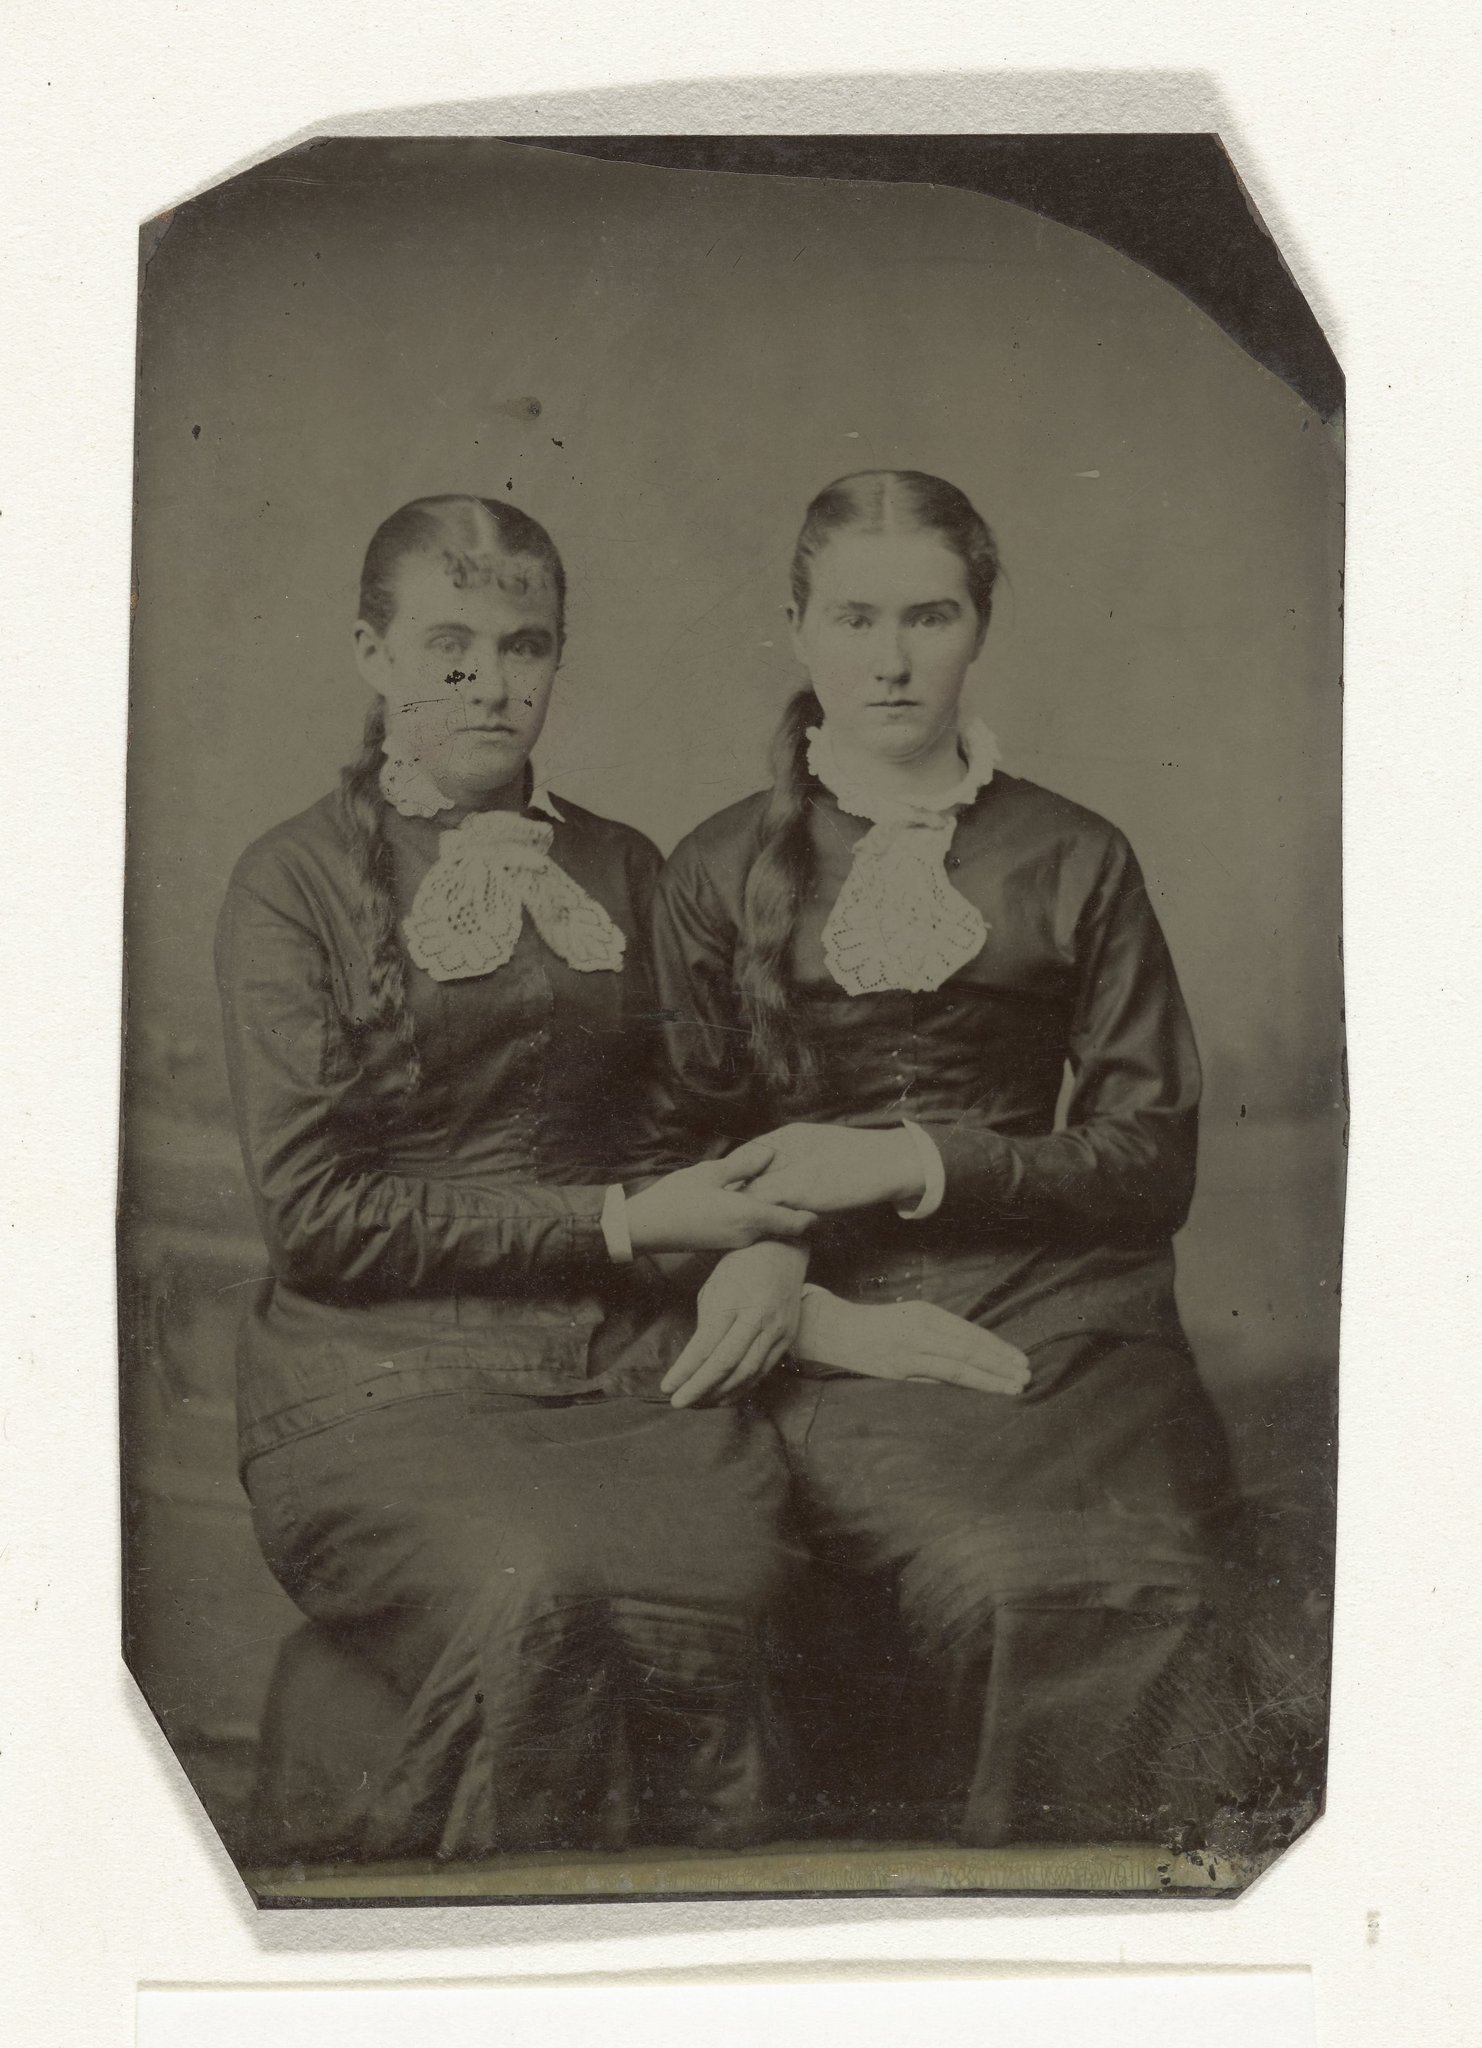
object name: photograph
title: Portrait of two women sitting side by side and holding each other's hands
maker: Anonymous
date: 1870-1900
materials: metal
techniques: ferrotyping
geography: united states